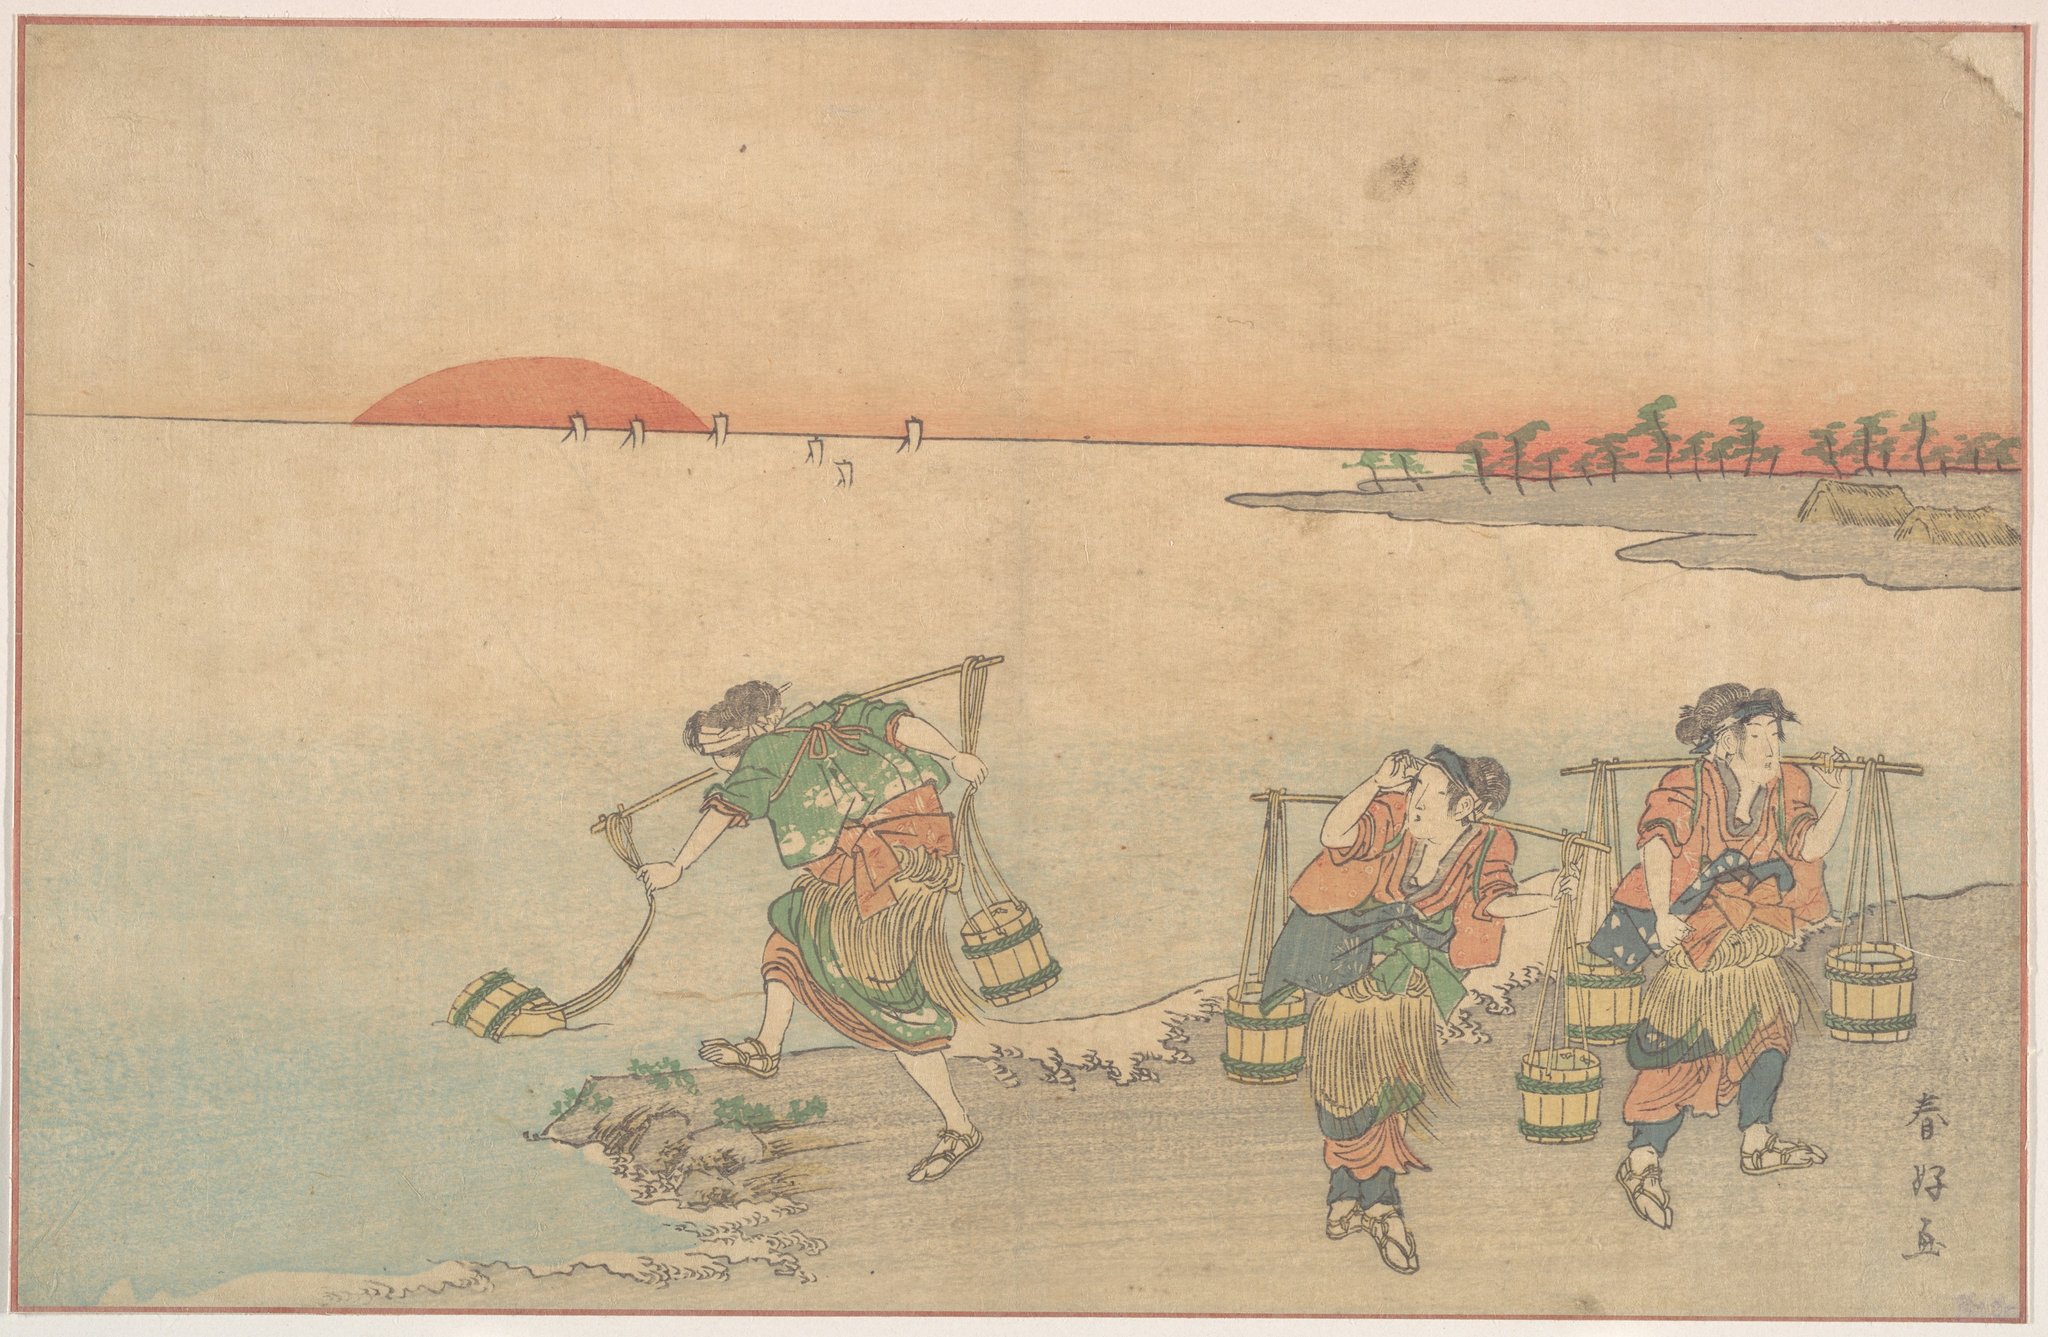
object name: print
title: Three Water Carriers at the Shore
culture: japanese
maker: katsukawa shunkō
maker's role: artist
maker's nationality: japanese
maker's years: 1743-1812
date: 1743-1812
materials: ink, paper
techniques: woodblock print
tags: women